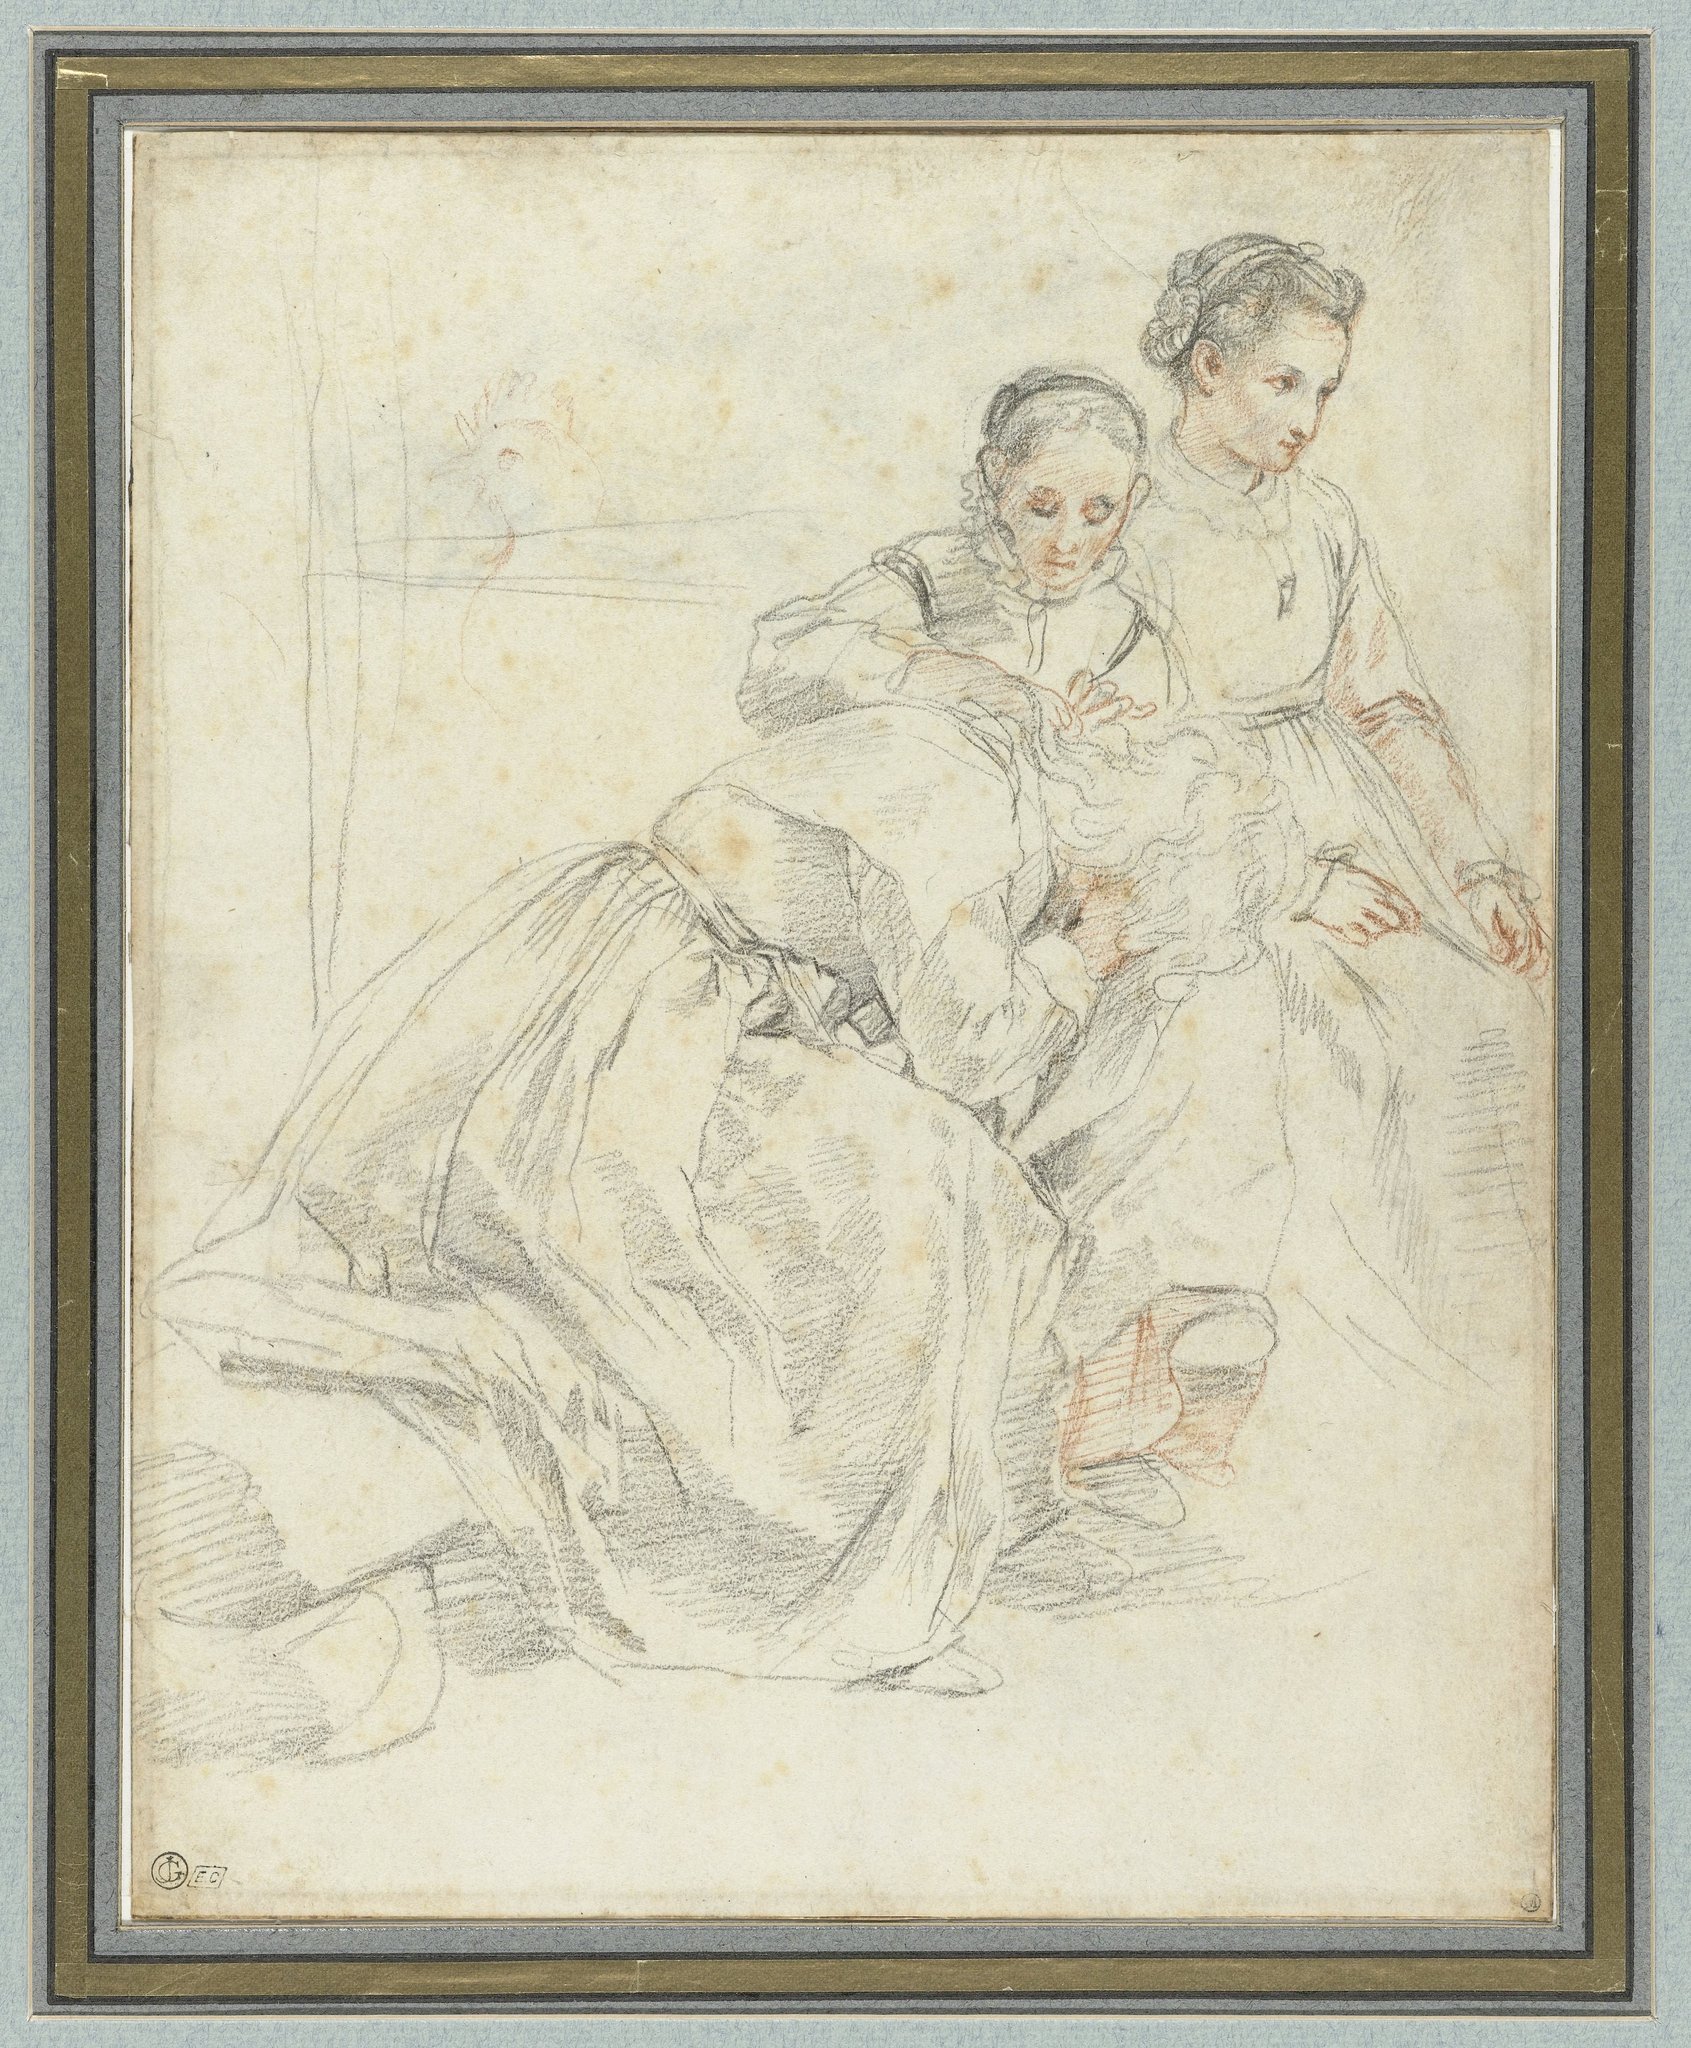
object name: drawing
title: Drie zittende vrouwen waarvan één het haar van een ander onderzoekt op luizen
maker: federico barocci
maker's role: draughtsman, painter, print maker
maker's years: 1528-1612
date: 1597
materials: chalk, paper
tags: looking for fleas - aa - female human figure, sitting figure - aa - female human figure, 'motherly care', delousing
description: Drie zittende vrouwen. De vrouw links heeft haar hoofd in de schoot van de middelste vrouw gelegd, die in haar haar op zoek is naar luizen; de vrouw rechts kijkt naar rechts het beeld uit.